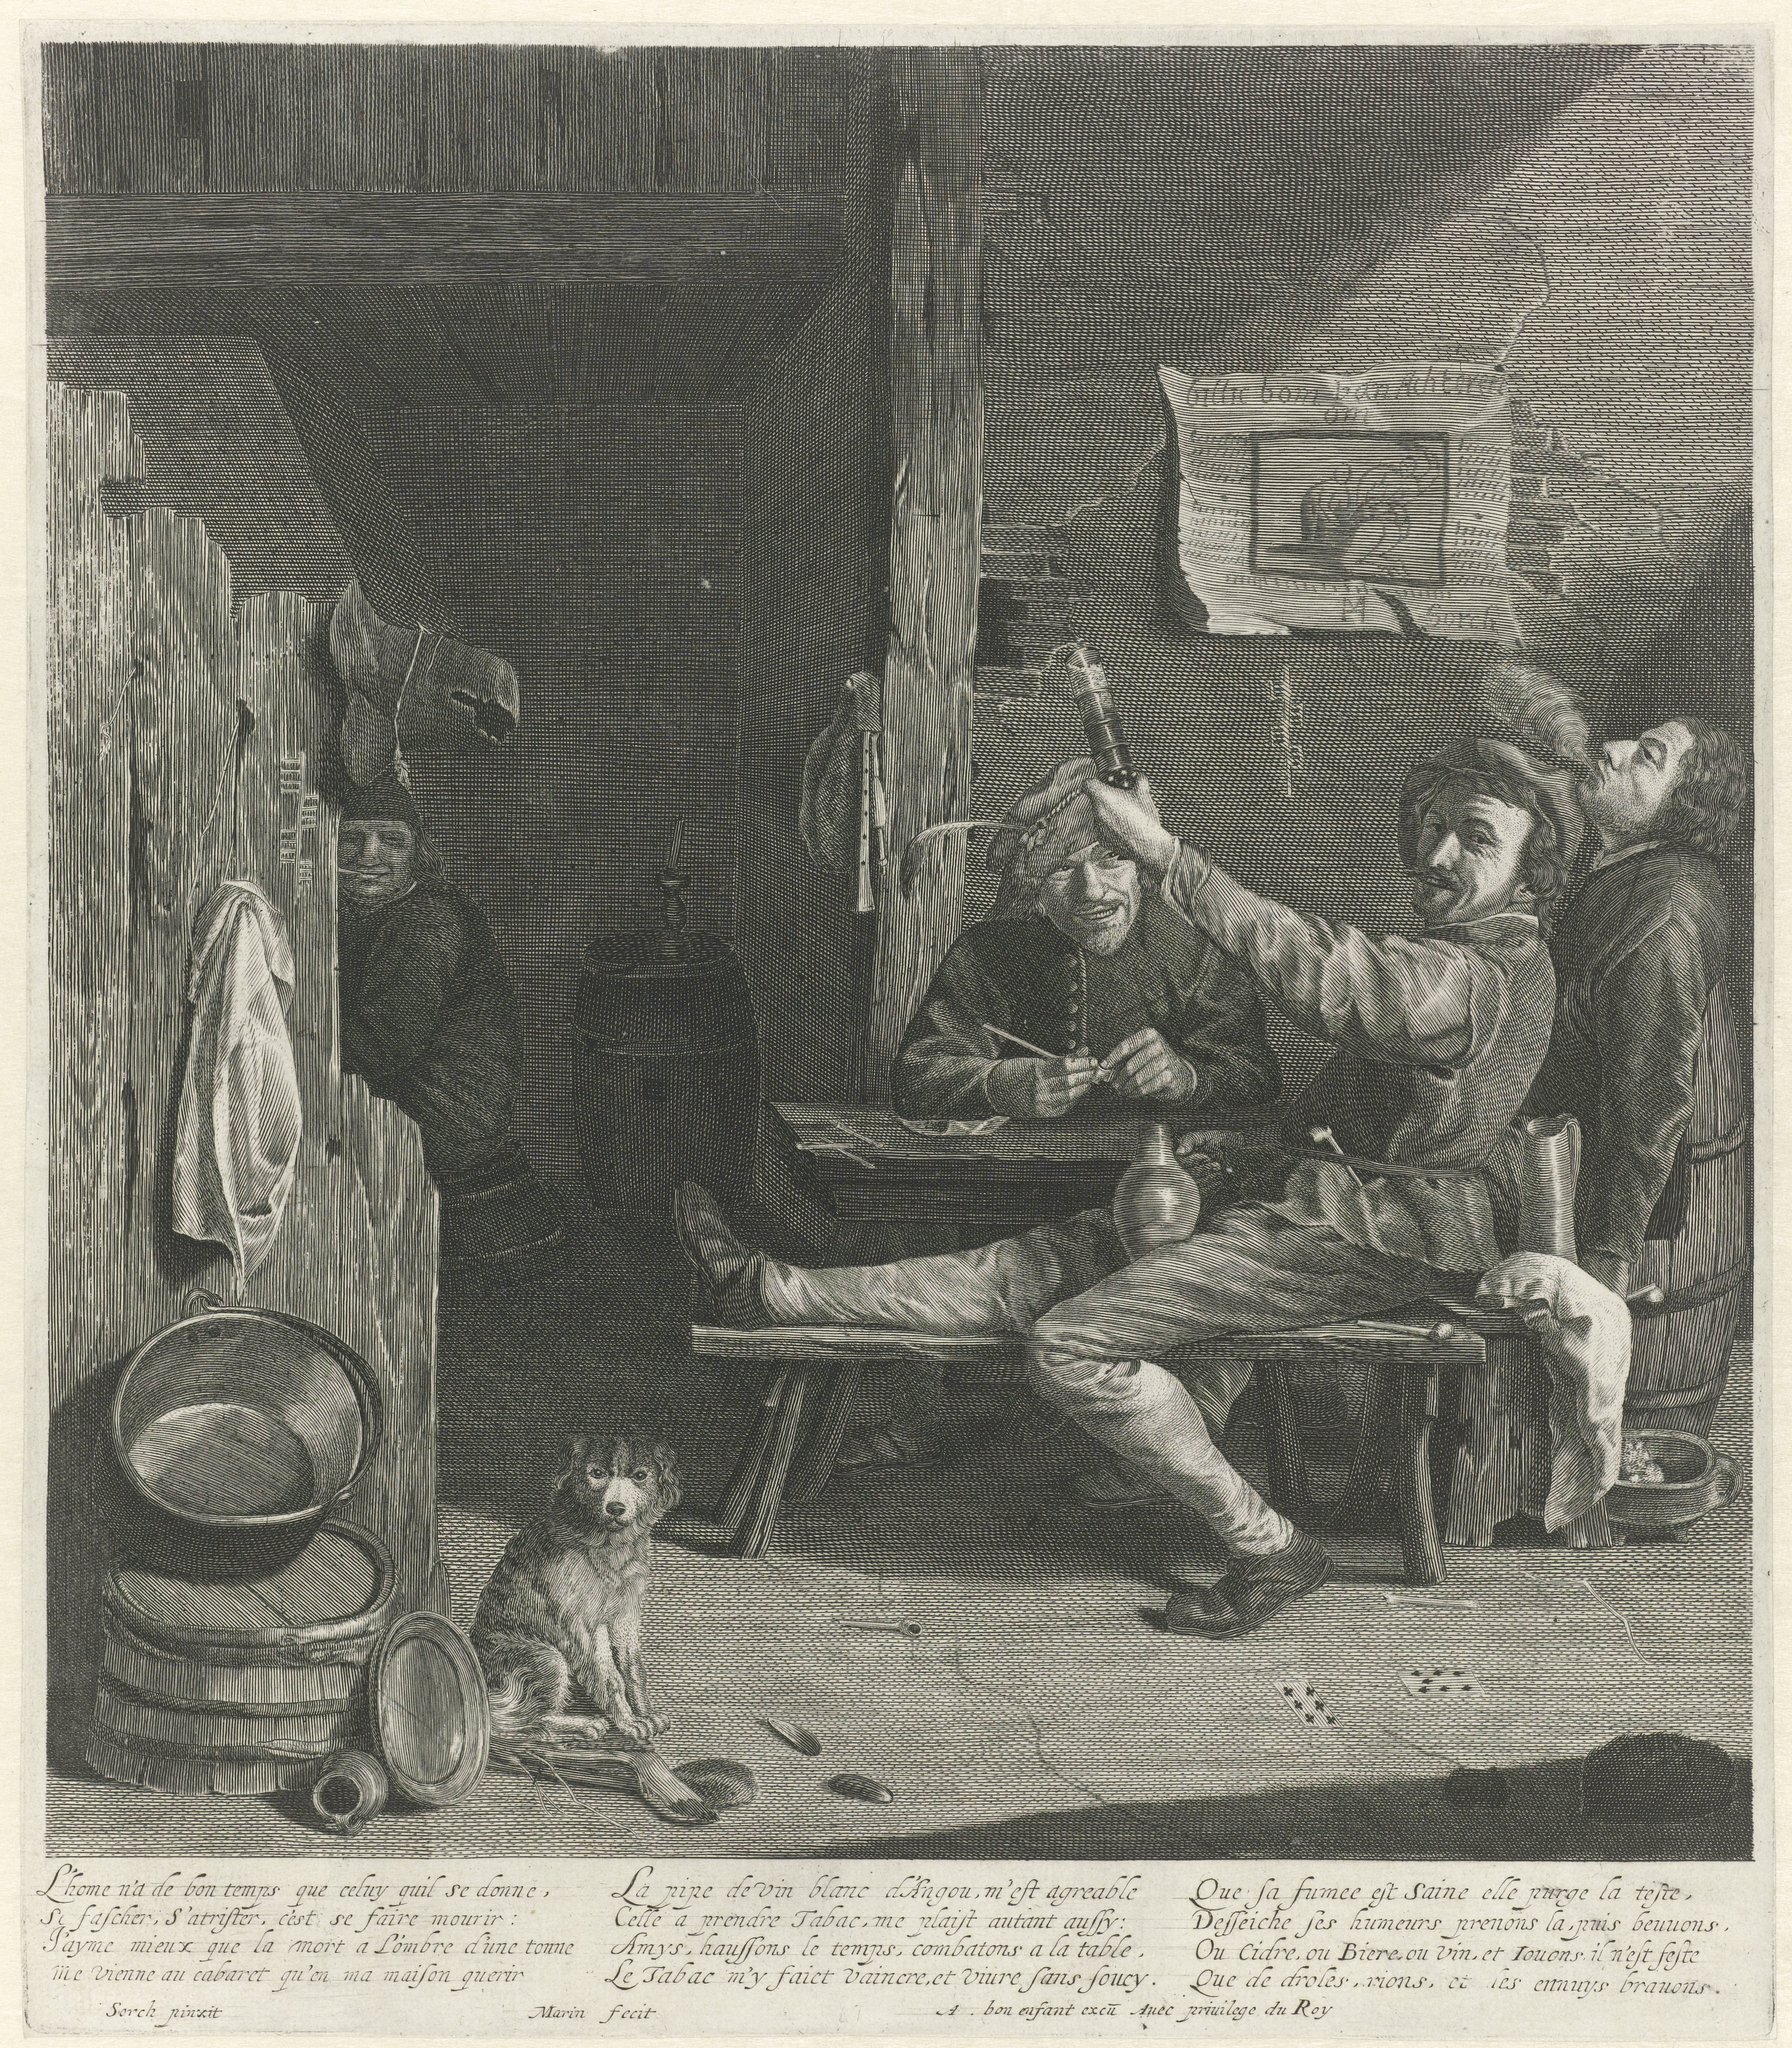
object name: print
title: Herberginterieur met drinkende en rokende heren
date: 1609-1639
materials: paper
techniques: engraving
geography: antwerp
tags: inn, coffee-house, public house, etc., pipe ~ tobacco, drinking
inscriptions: collector's mark: Lugt 240